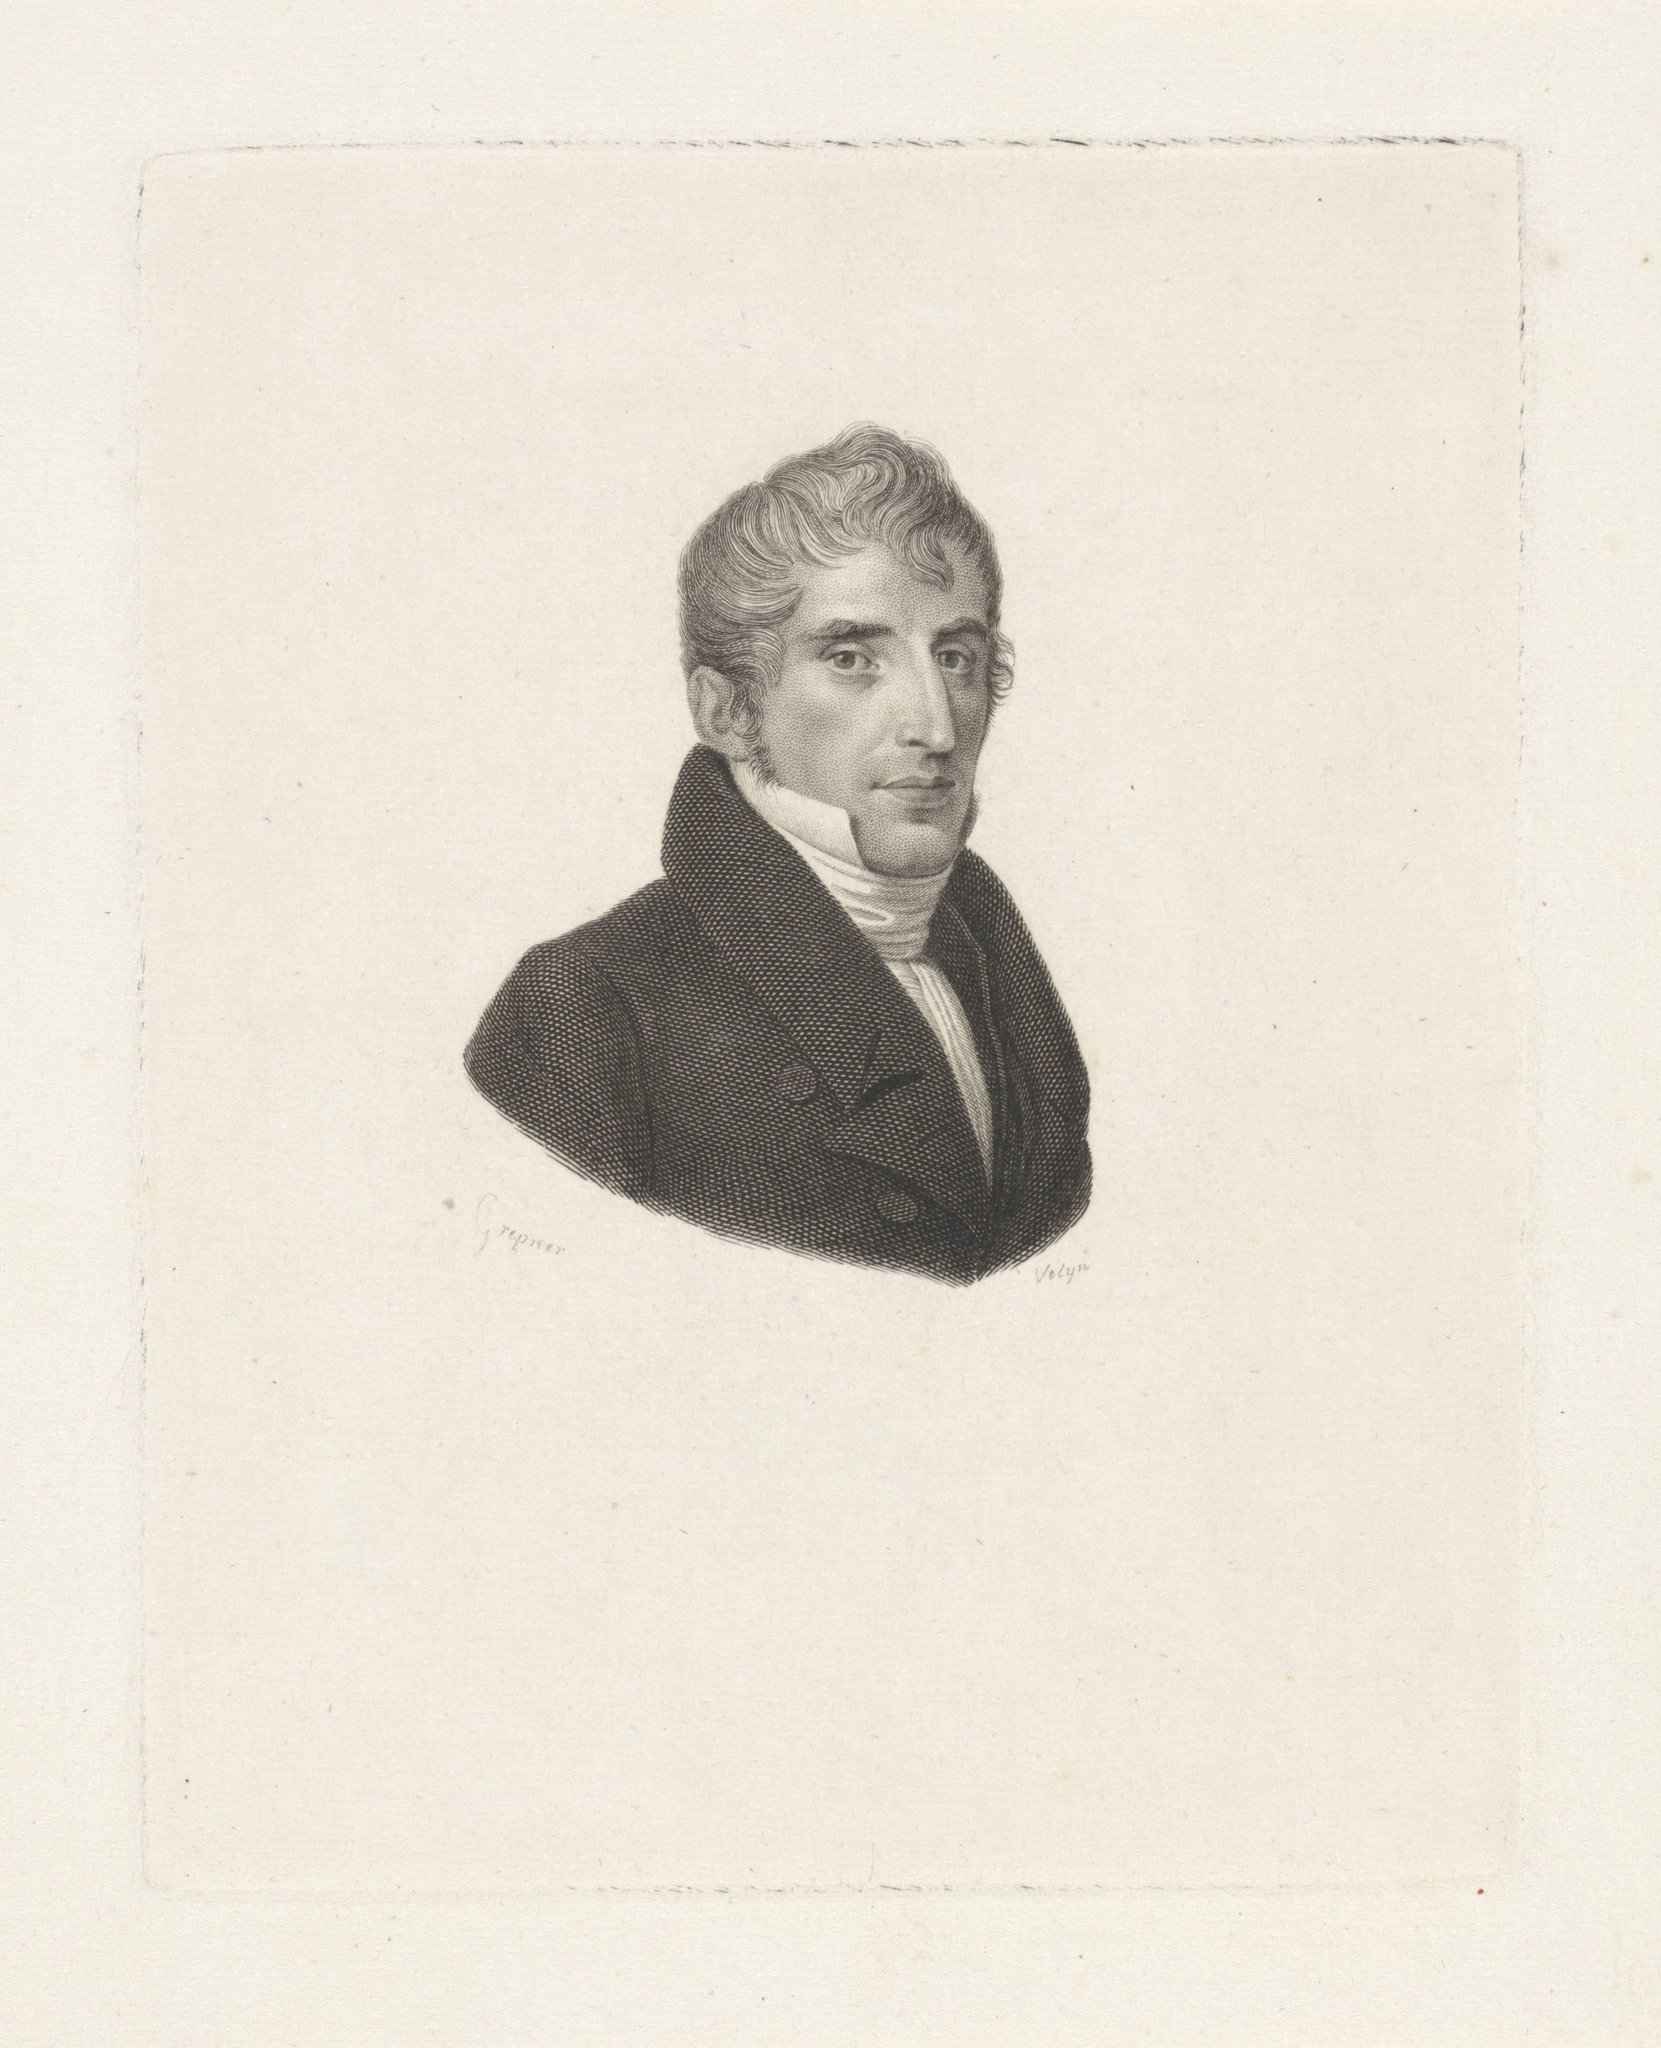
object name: print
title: Portret van Willem Hendrik Warnsinck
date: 1831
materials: paper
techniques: engraving, etching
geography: netherlands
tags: amsterdam, willem hendrik warnsinck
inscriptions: collector's mark: Lugt 2228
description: Prent volgens Van Someren ook gebruikt in: Nederlandsche Muzen-Almanak. Rotterdam: J. Immerzeel, 1831.